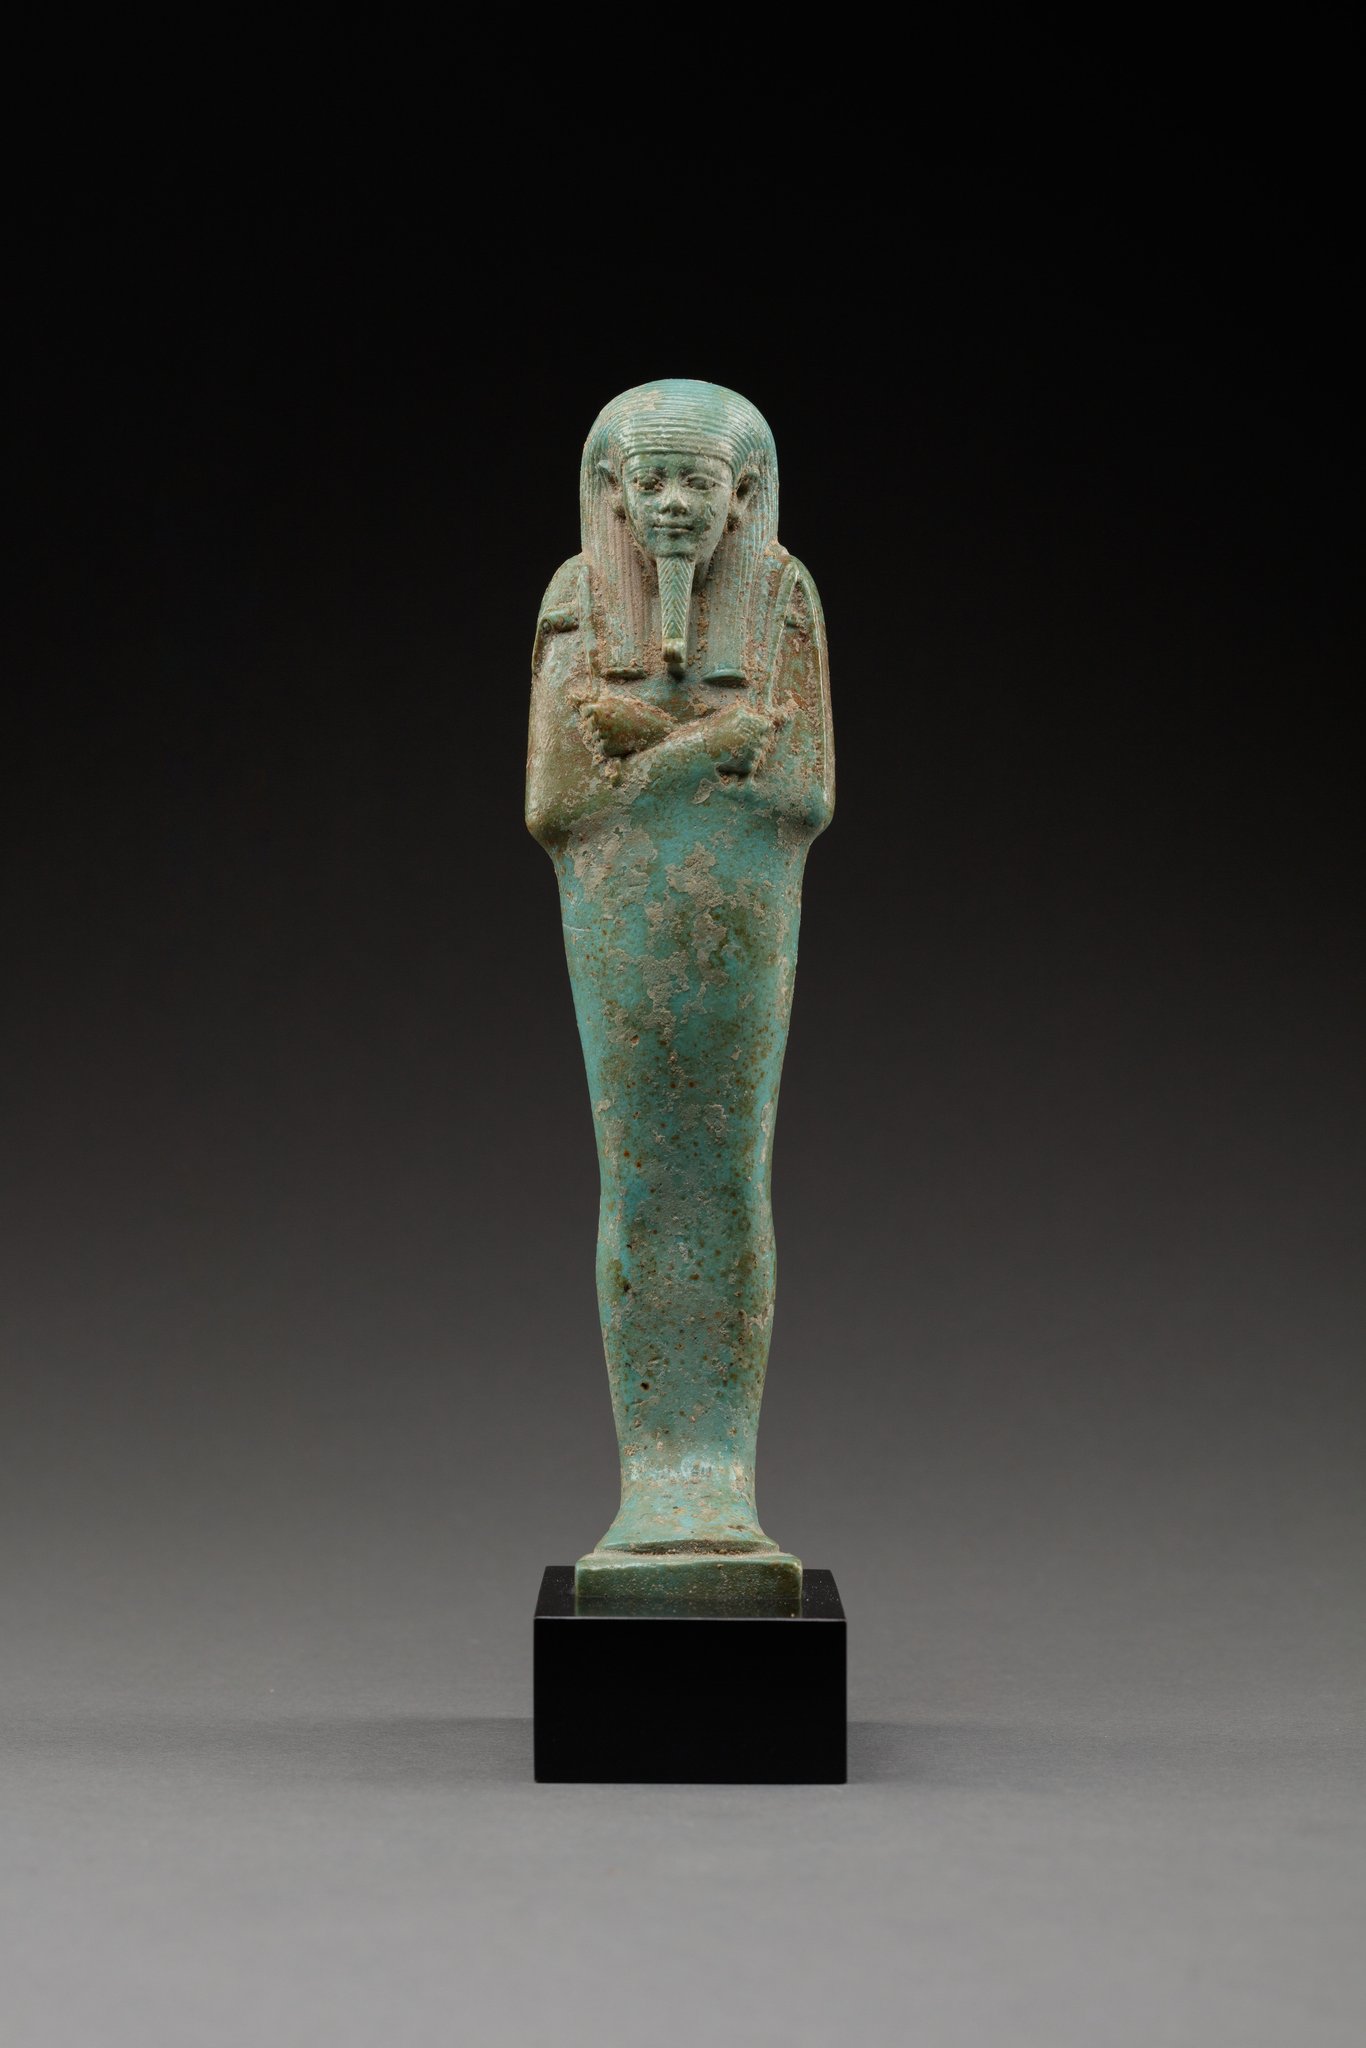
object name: shabti ushabti of the overseer of the fleet, hekaemsaf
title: Shabti of the Overseer of the Fleet Hekaemsaf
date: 570-526 BCE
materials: faience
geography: memphite region